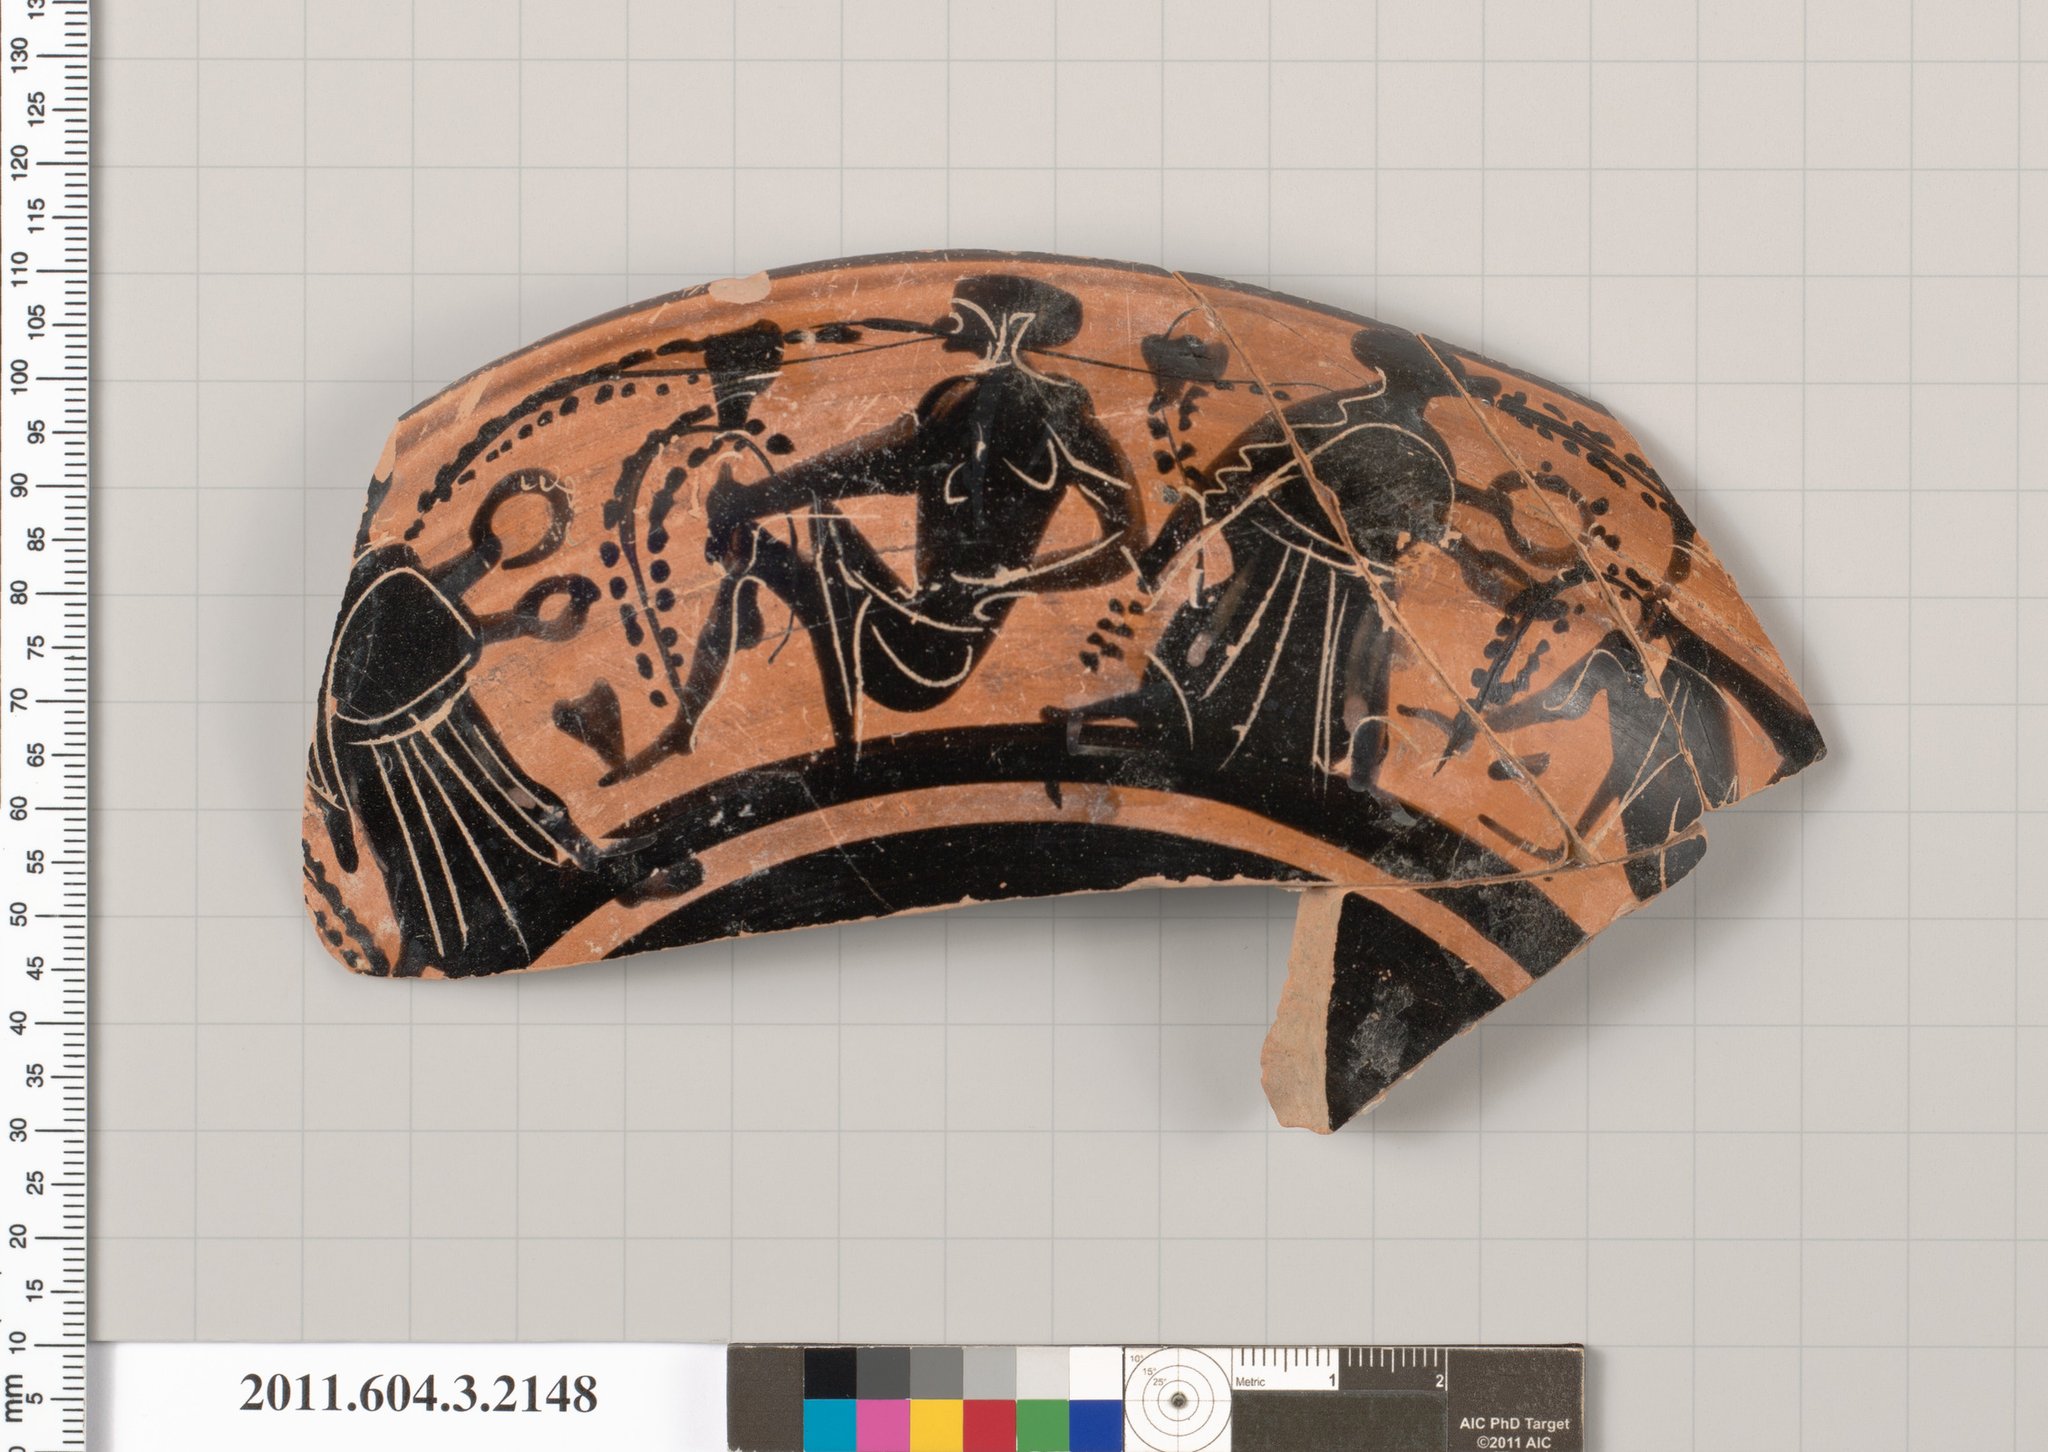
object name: kylix fragment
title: Terracotta rim fragment of a kylix (drinking cup)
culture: greek, attic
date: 500-480 BCE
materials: terracotta